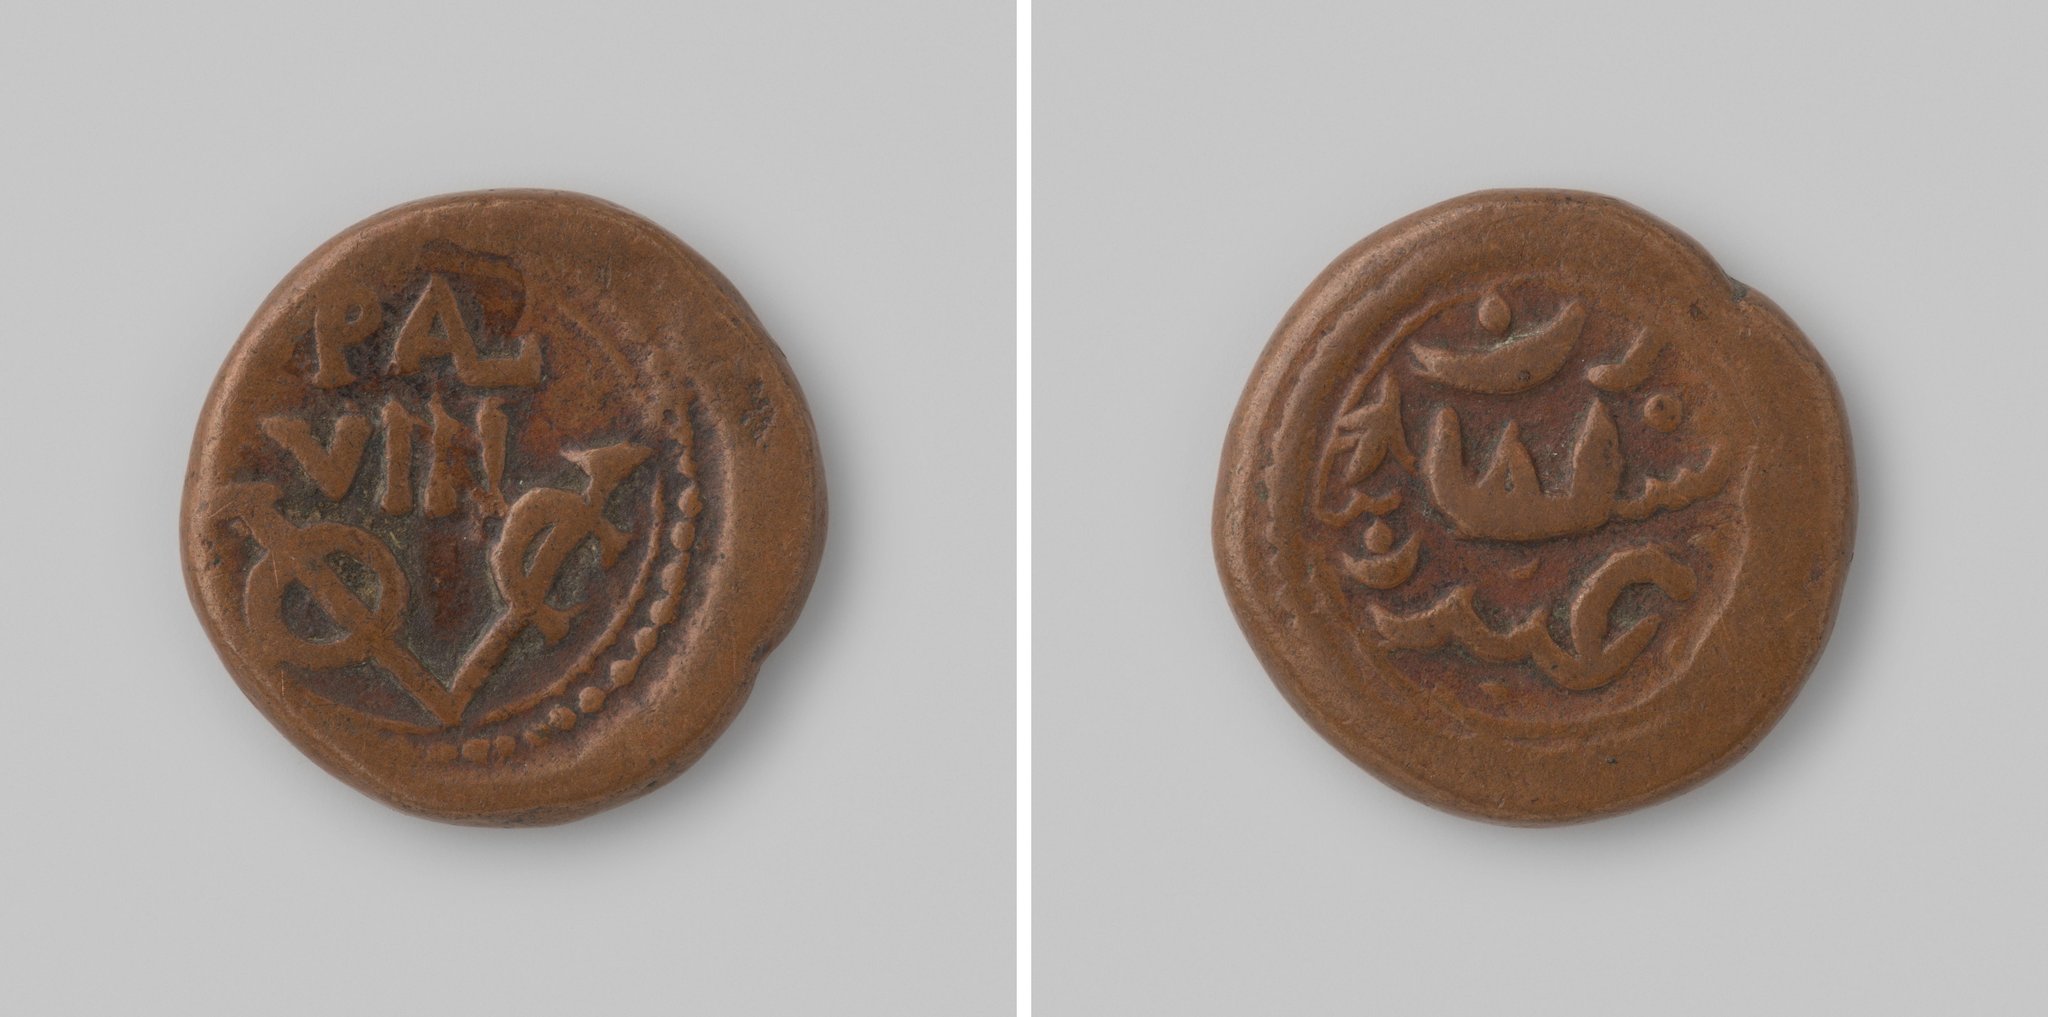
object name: coin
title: Koperen acht kas uit Paliakatte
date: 1646-1700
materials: copper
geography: paliacatta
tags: paliacatta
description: Min of meer ronde munt met op voorzijde: VOC beeldmerk met daarboven PAL (slecht leesbaar) / VIII / VOC-beeldmerk. Keerzijde: in het arabisch het opschrift: Heer / Koning / Knecht.